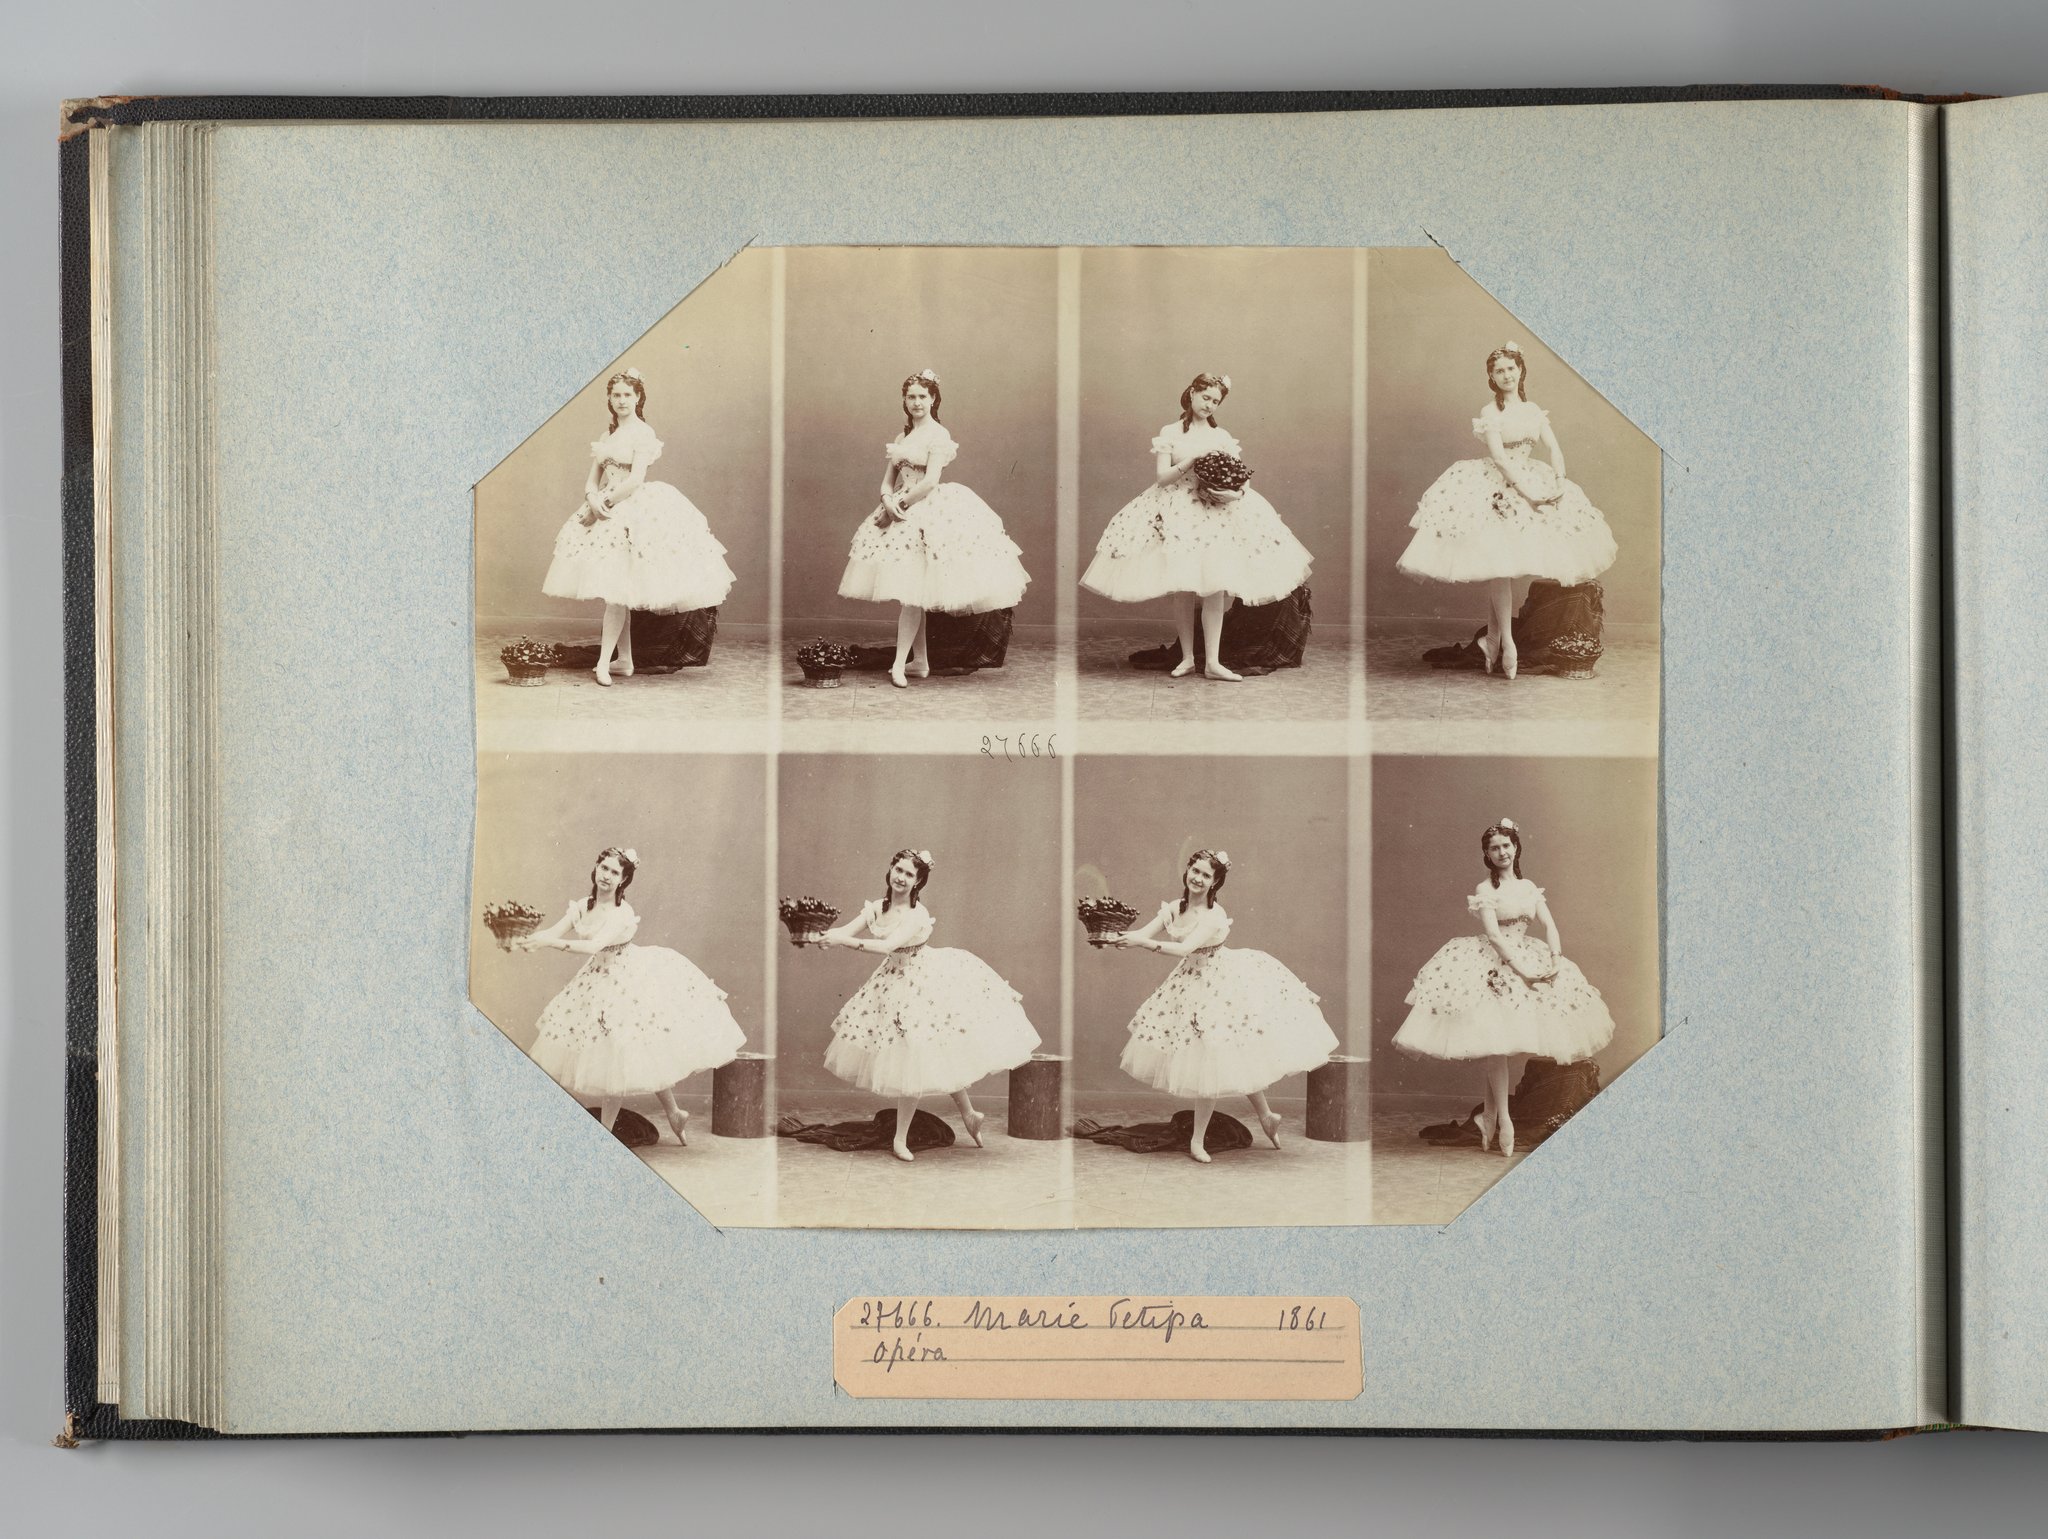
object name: photograph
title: Marie Petipa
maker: andré-adolphe-eugène disdéri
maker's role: artist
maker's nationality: french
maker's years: 1819-1889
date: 1861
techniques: albumen silver print, glass negative